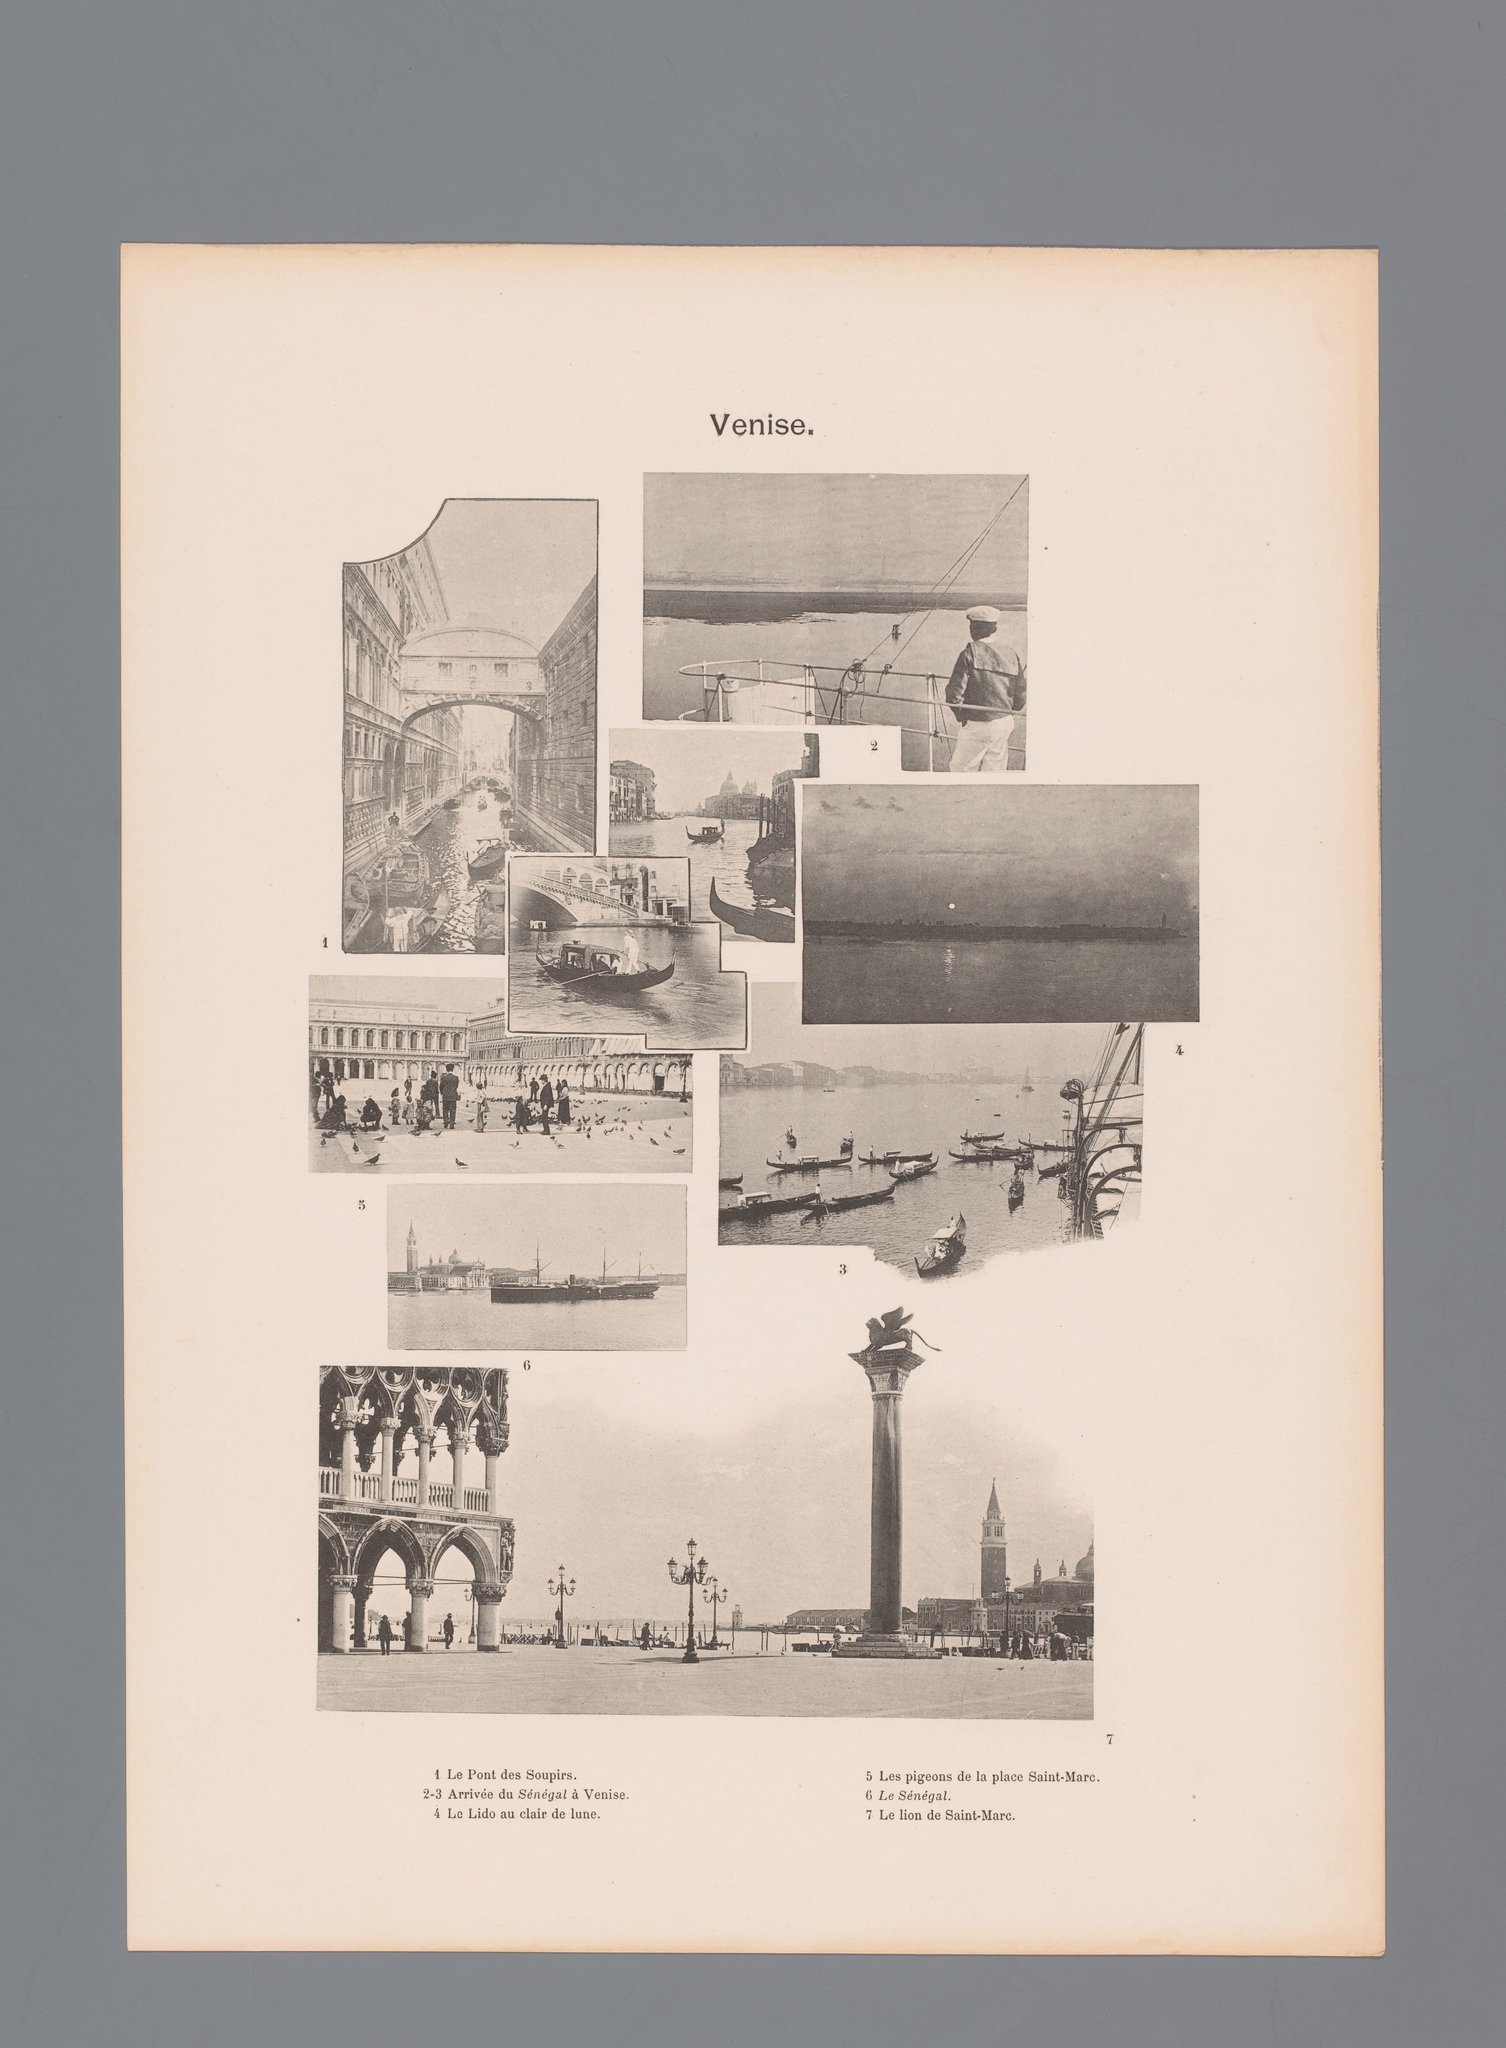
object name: photomechanical print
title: Venise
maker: Anonymous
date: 1893-1898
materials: paper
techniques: photograph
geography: venice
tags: rowing-boat, canoe, etc., prospect of city, town panorama, silhouette of city, venice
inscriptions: inscription: ‘1 Le Pont des Soupirs./ 2-3 Arrivée du Sénégal à Venise./ 4 Le Lido au clair de lune./ 5 Les pigeons de la place Saint-Marc./ 6 Le Sénégal./ 7 Le lion de Saint-Marc.’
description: Deze prenten maken deel uit van een omslag met 103 prenten op 16 bladen en een titelblad.